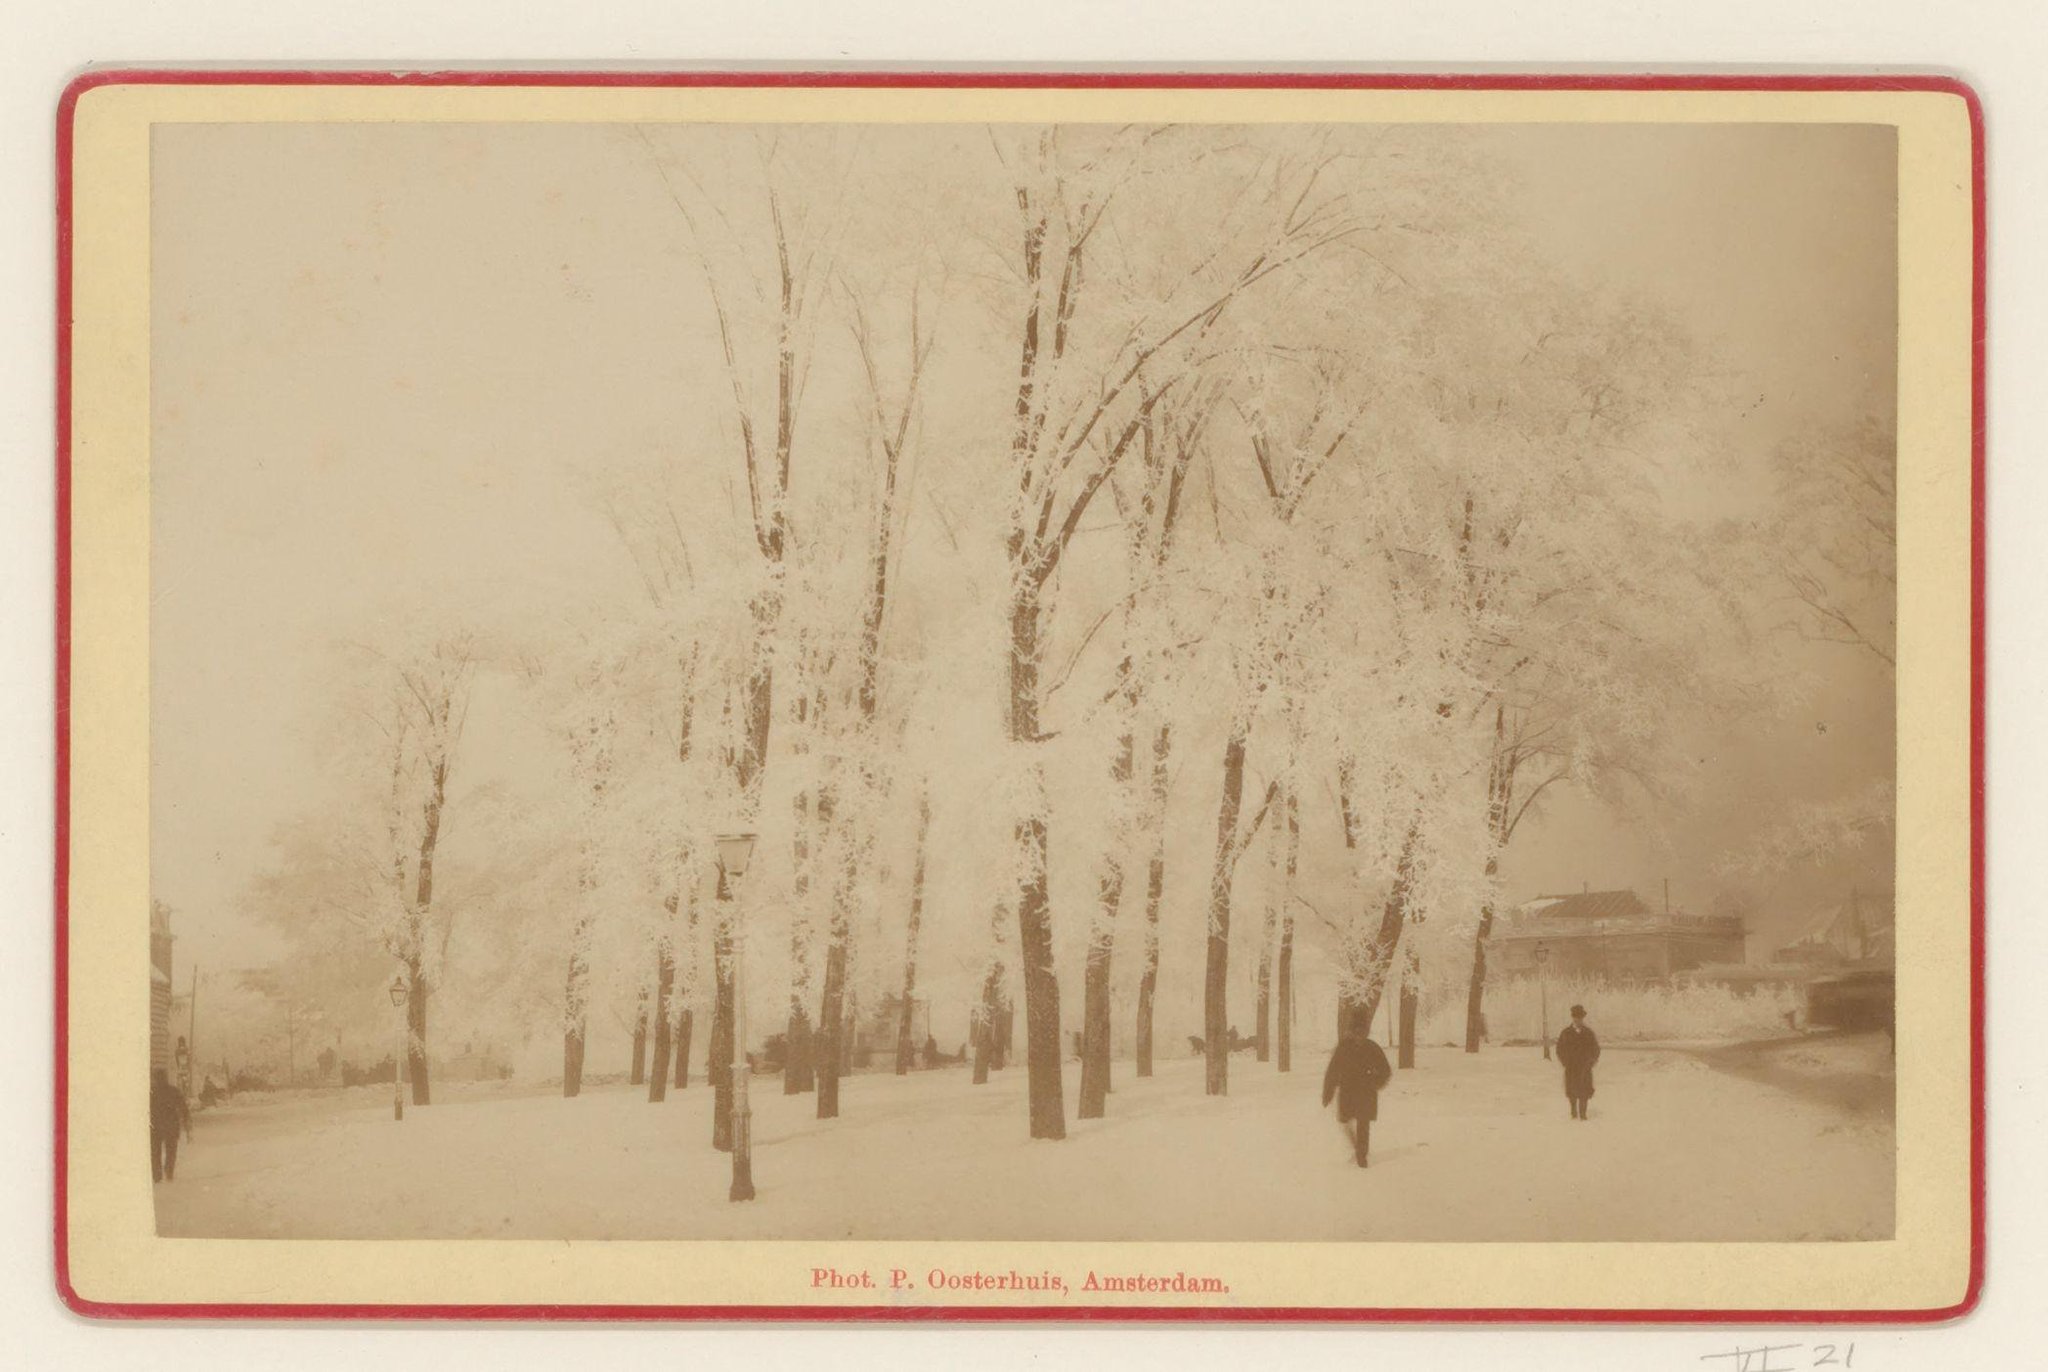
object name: cabinet photograph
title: Gezicht op het Leidsebosje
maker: pieter oosterhuis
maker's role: draughtsman, print maker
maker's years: 1816-1885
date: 1826-1885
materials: cardboard, paper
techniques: albumen print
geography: amsterdam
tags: city-view in general; 'veduta', public gardens, park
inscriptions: inscription: ‘Leidsche boschje’, collector's mark: ‘6’ Lugt 1641b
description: Onderwerpsrubriek binnen de Atlas Amsterdam: Buitensingel of wel: Gezichten langs en op de Stadsvest van Raampoort tot Zeeburgerdijk.